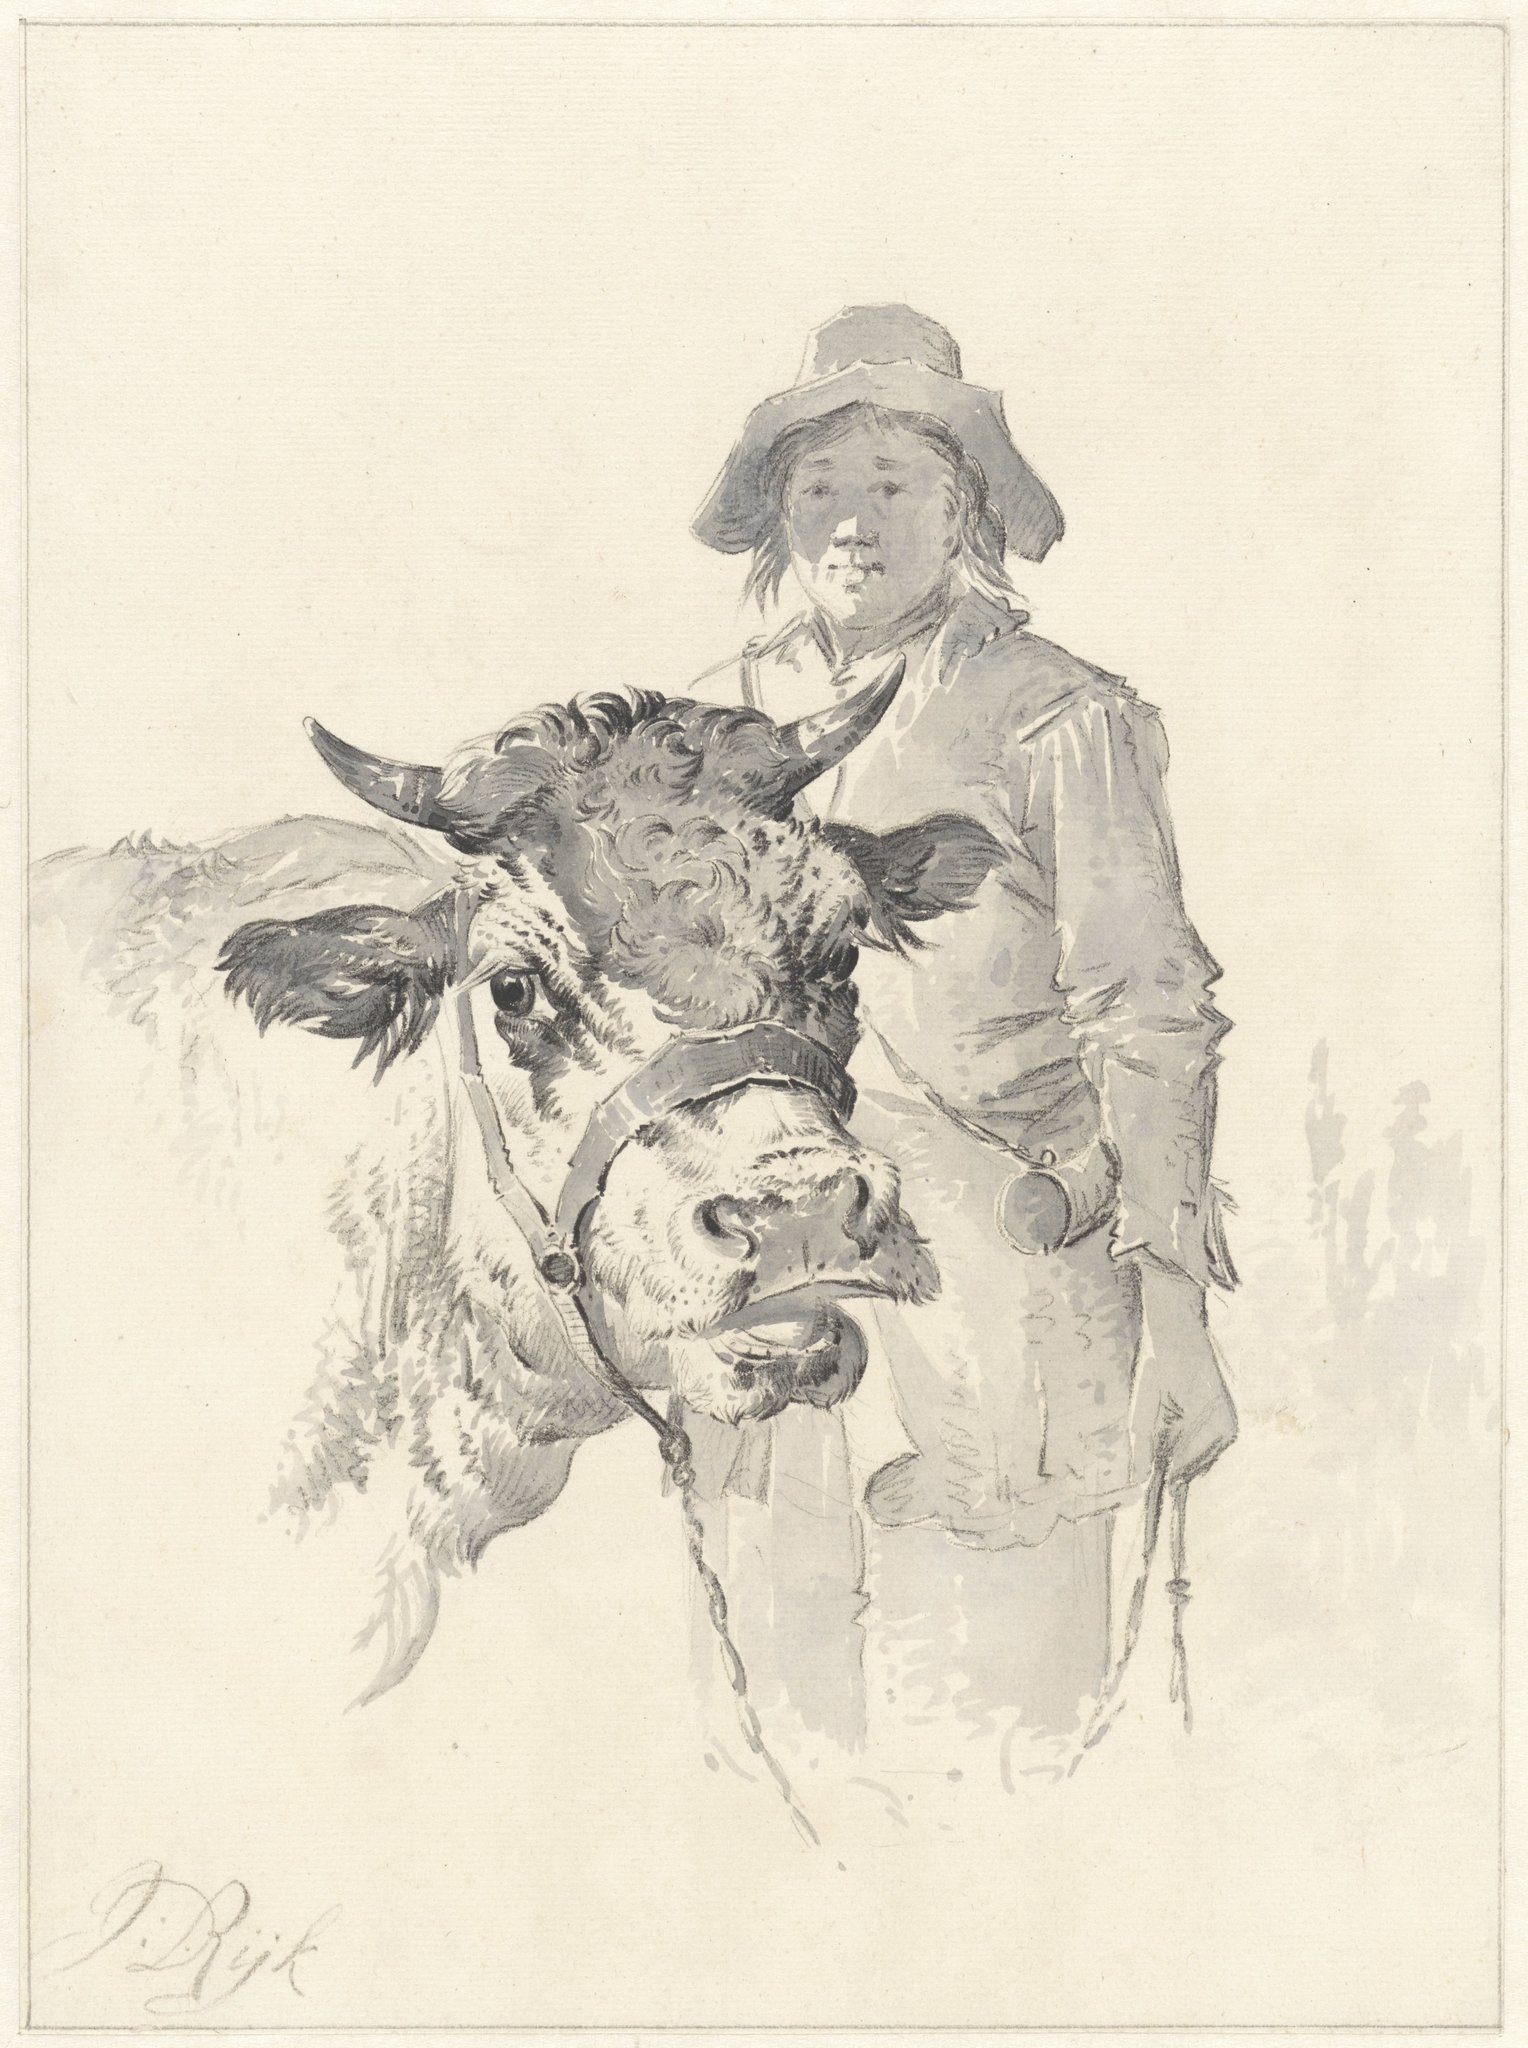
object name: drawing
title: Herder met stier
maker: james de rijk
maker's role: draughtsman, painter, print maker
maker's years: 1806-1882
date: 1816-1882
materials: chalk, paper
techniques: brush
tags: bull, herding, herdsman, herdswoman, shepherd, shepherdess, cowherd, etc.